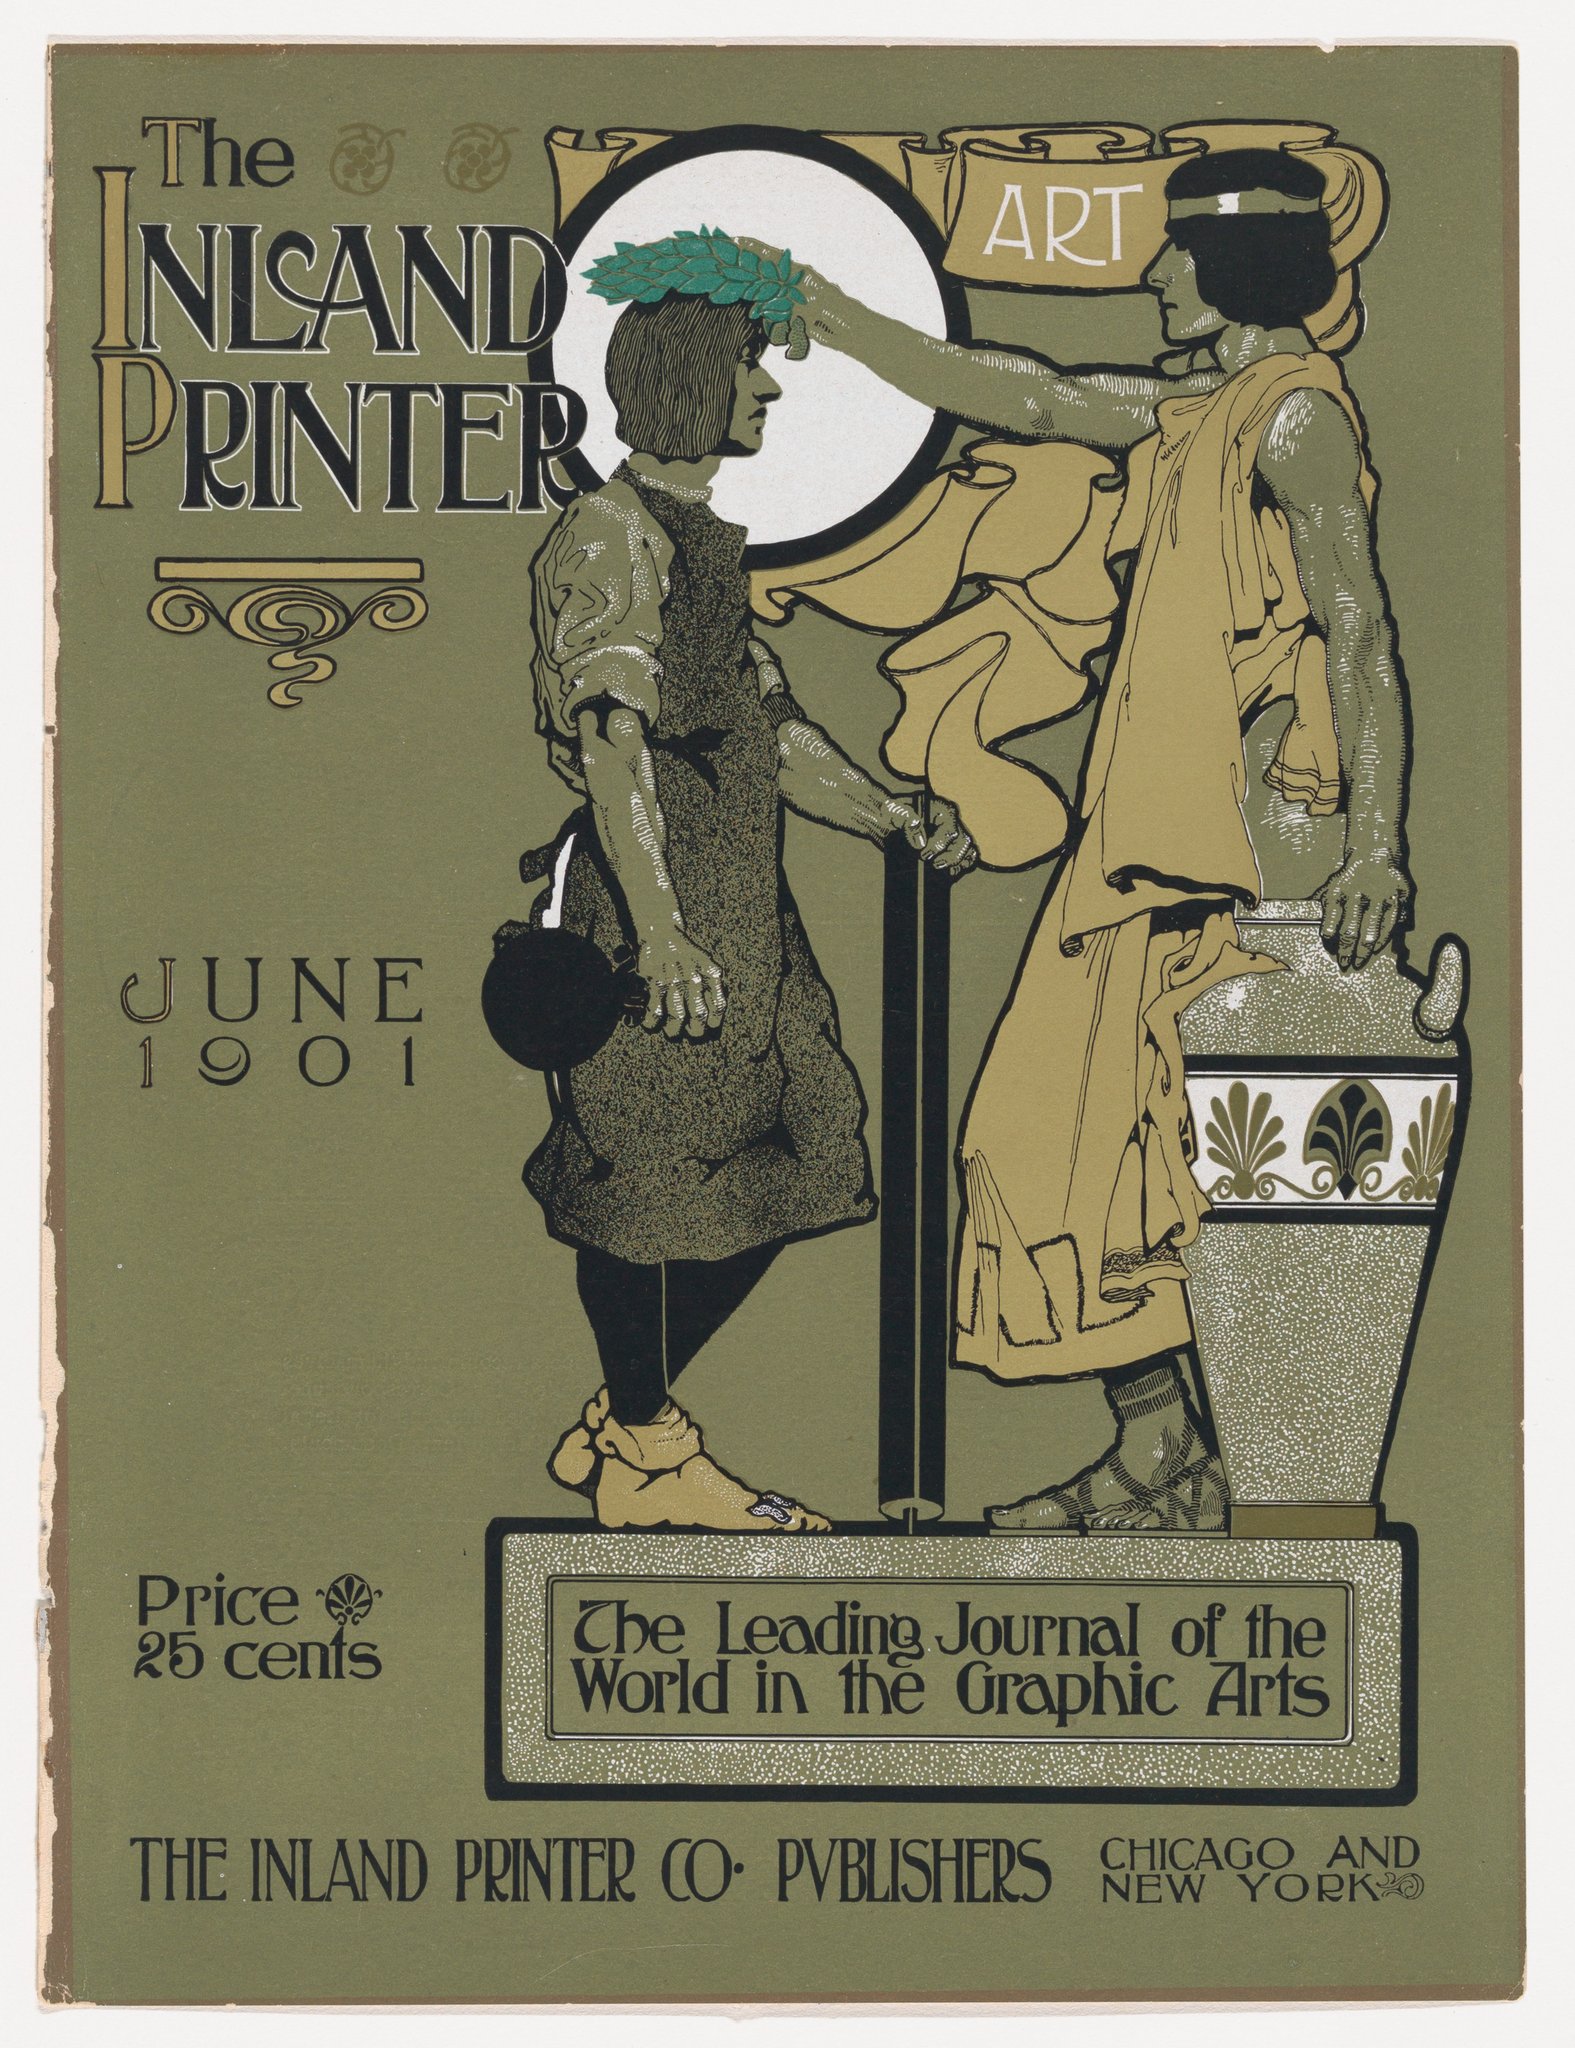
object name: poster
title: The Inland Printer, June 1901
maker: anonymous, american, 20th century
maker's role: artist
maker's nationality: american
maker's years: 1900-1999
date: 1901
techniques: lithograph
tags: men